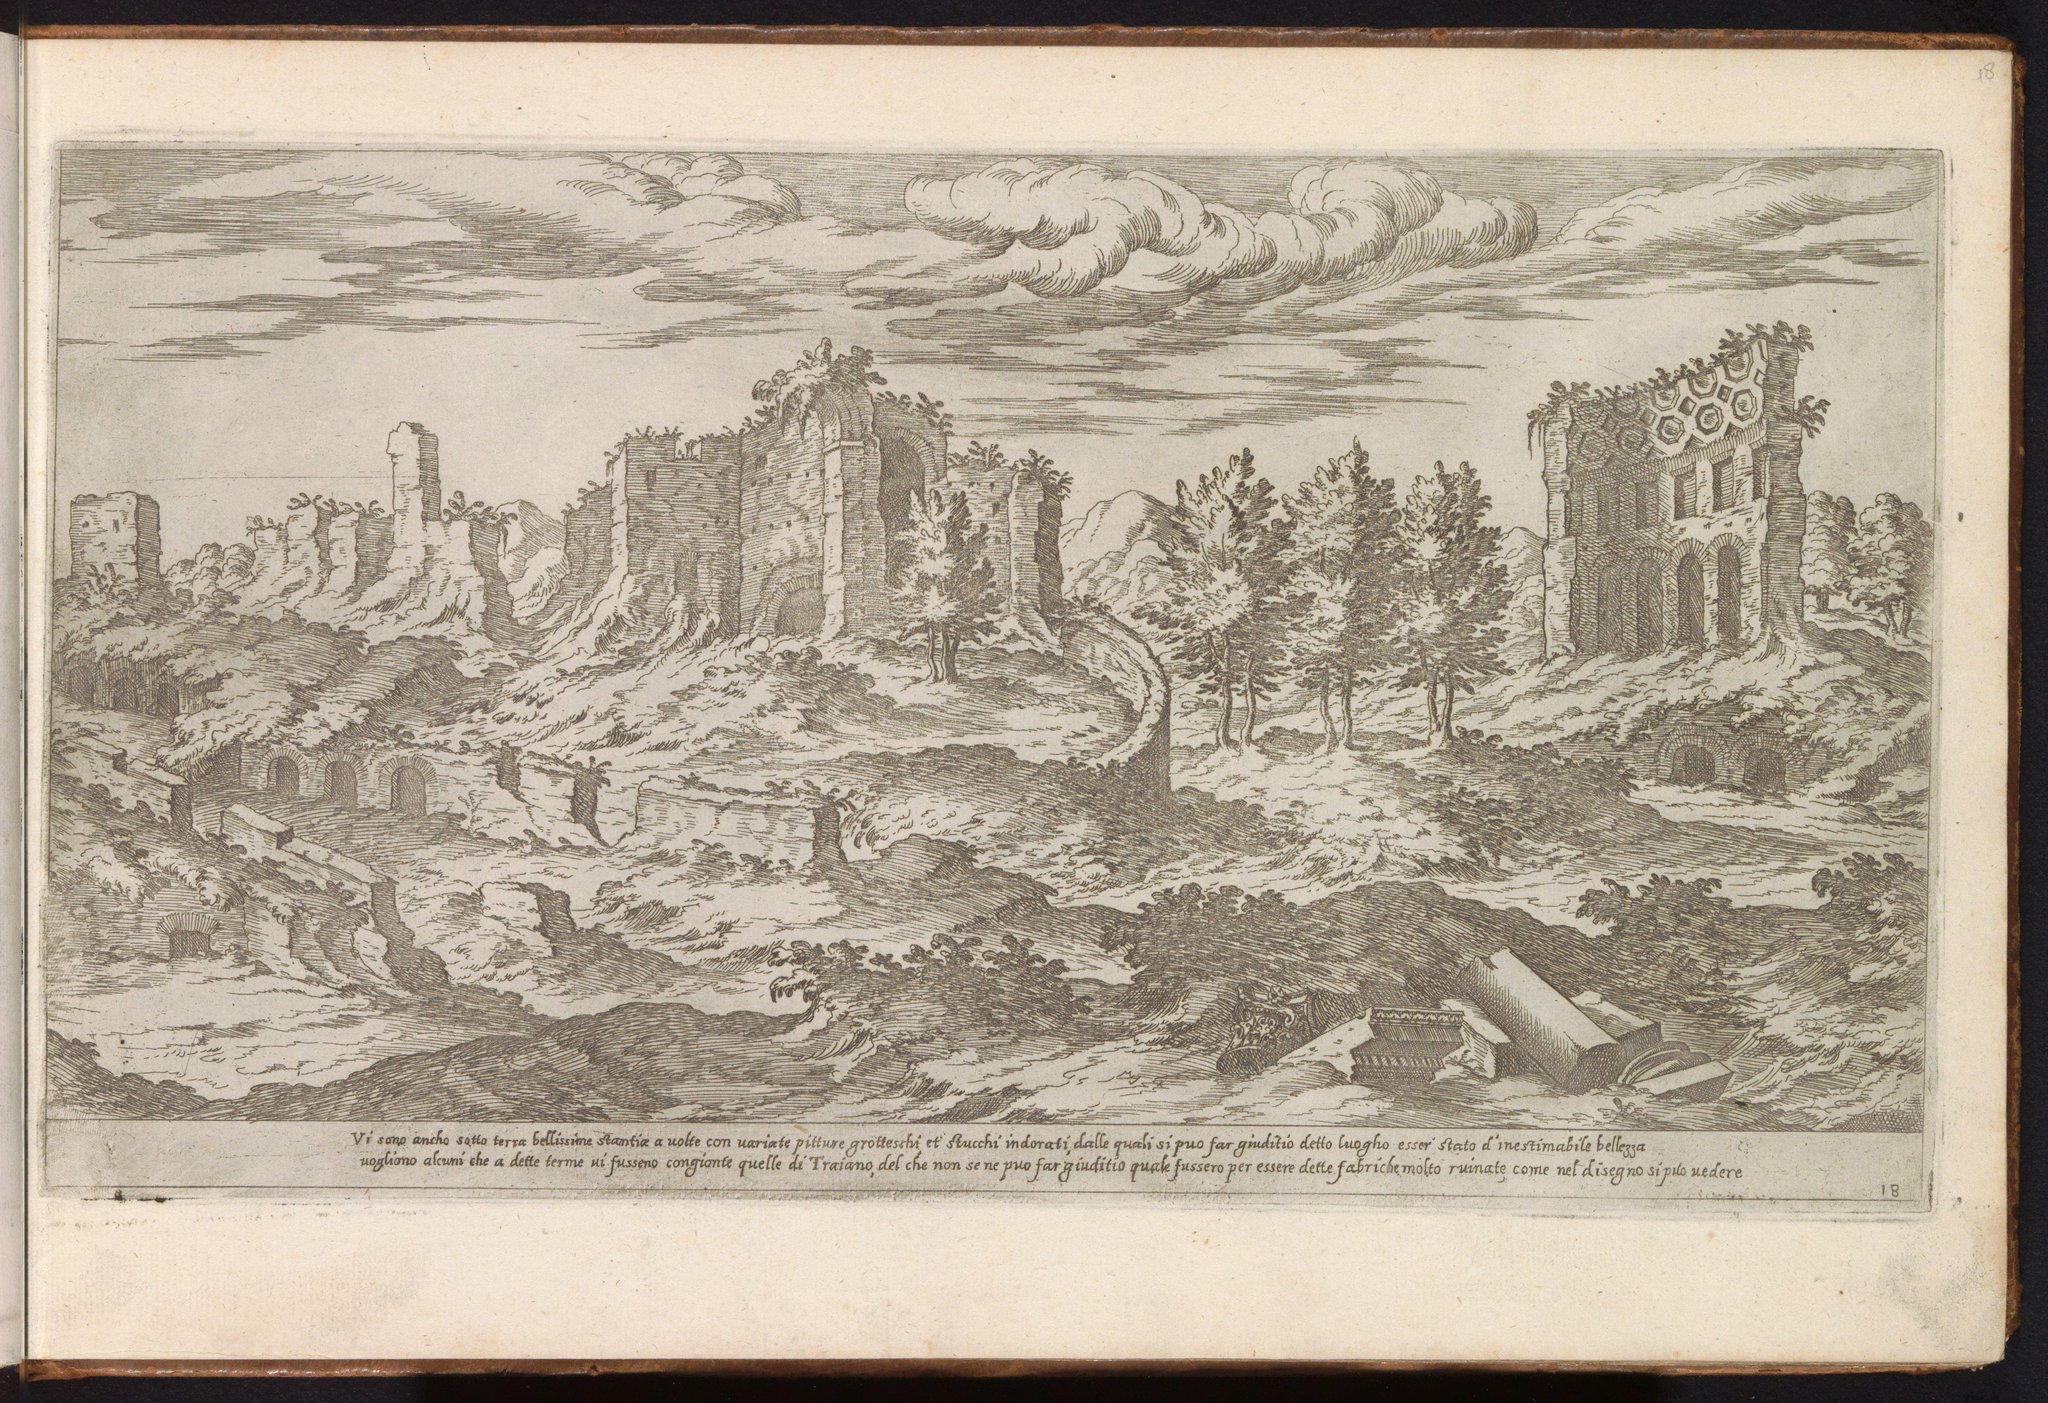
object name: album leaf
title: Bouwwerken uit de oudheid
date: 1575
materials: paper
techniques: engraving, etching, intaglio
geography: vatican city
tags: city-view, and landscape with man-made constructions, ruin of a building ~ architecture, landscape with ruins, public baths - aa - in the open air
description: Gezicht op de ruïnes van de Thermen van Trajanus te Rome. Onderschrift in het Italiaans. Prent maakt deel uit van een album.